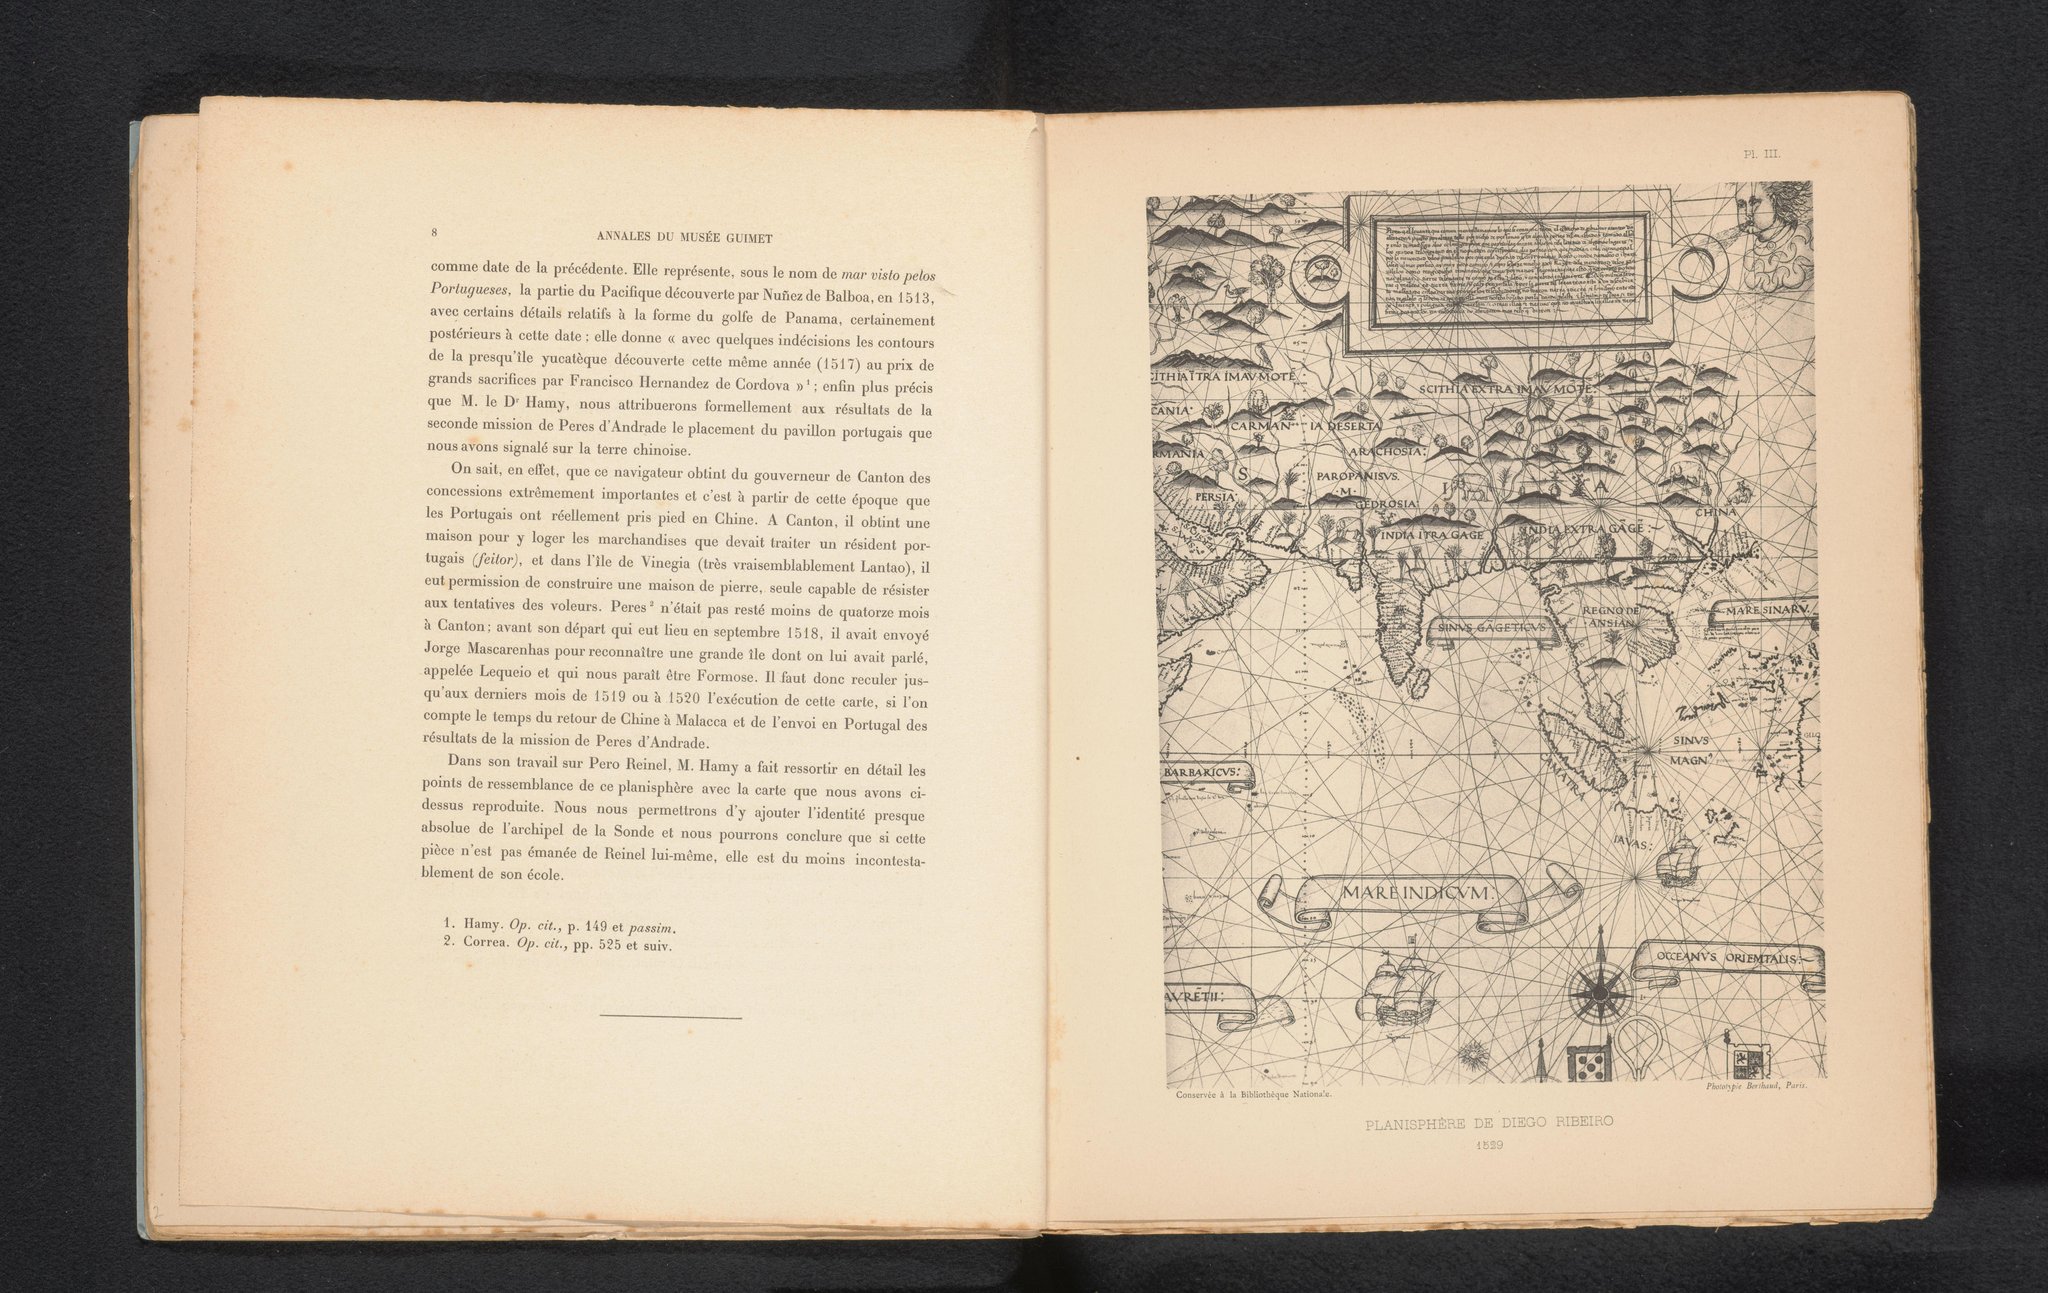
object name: reproduction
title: Reproductie van een landkaart door Diogo Ribeiro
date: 1890-1895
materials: paper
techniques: photograph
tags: maps, atlases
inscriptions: collector's mark: ‘Société d'Emulation de l'Ain/ Bourg/ Bibliothèque’, inscription: ‘1529’, inscription: ‘Pl. III/ Conservée à la Bibliothèque Nationale’